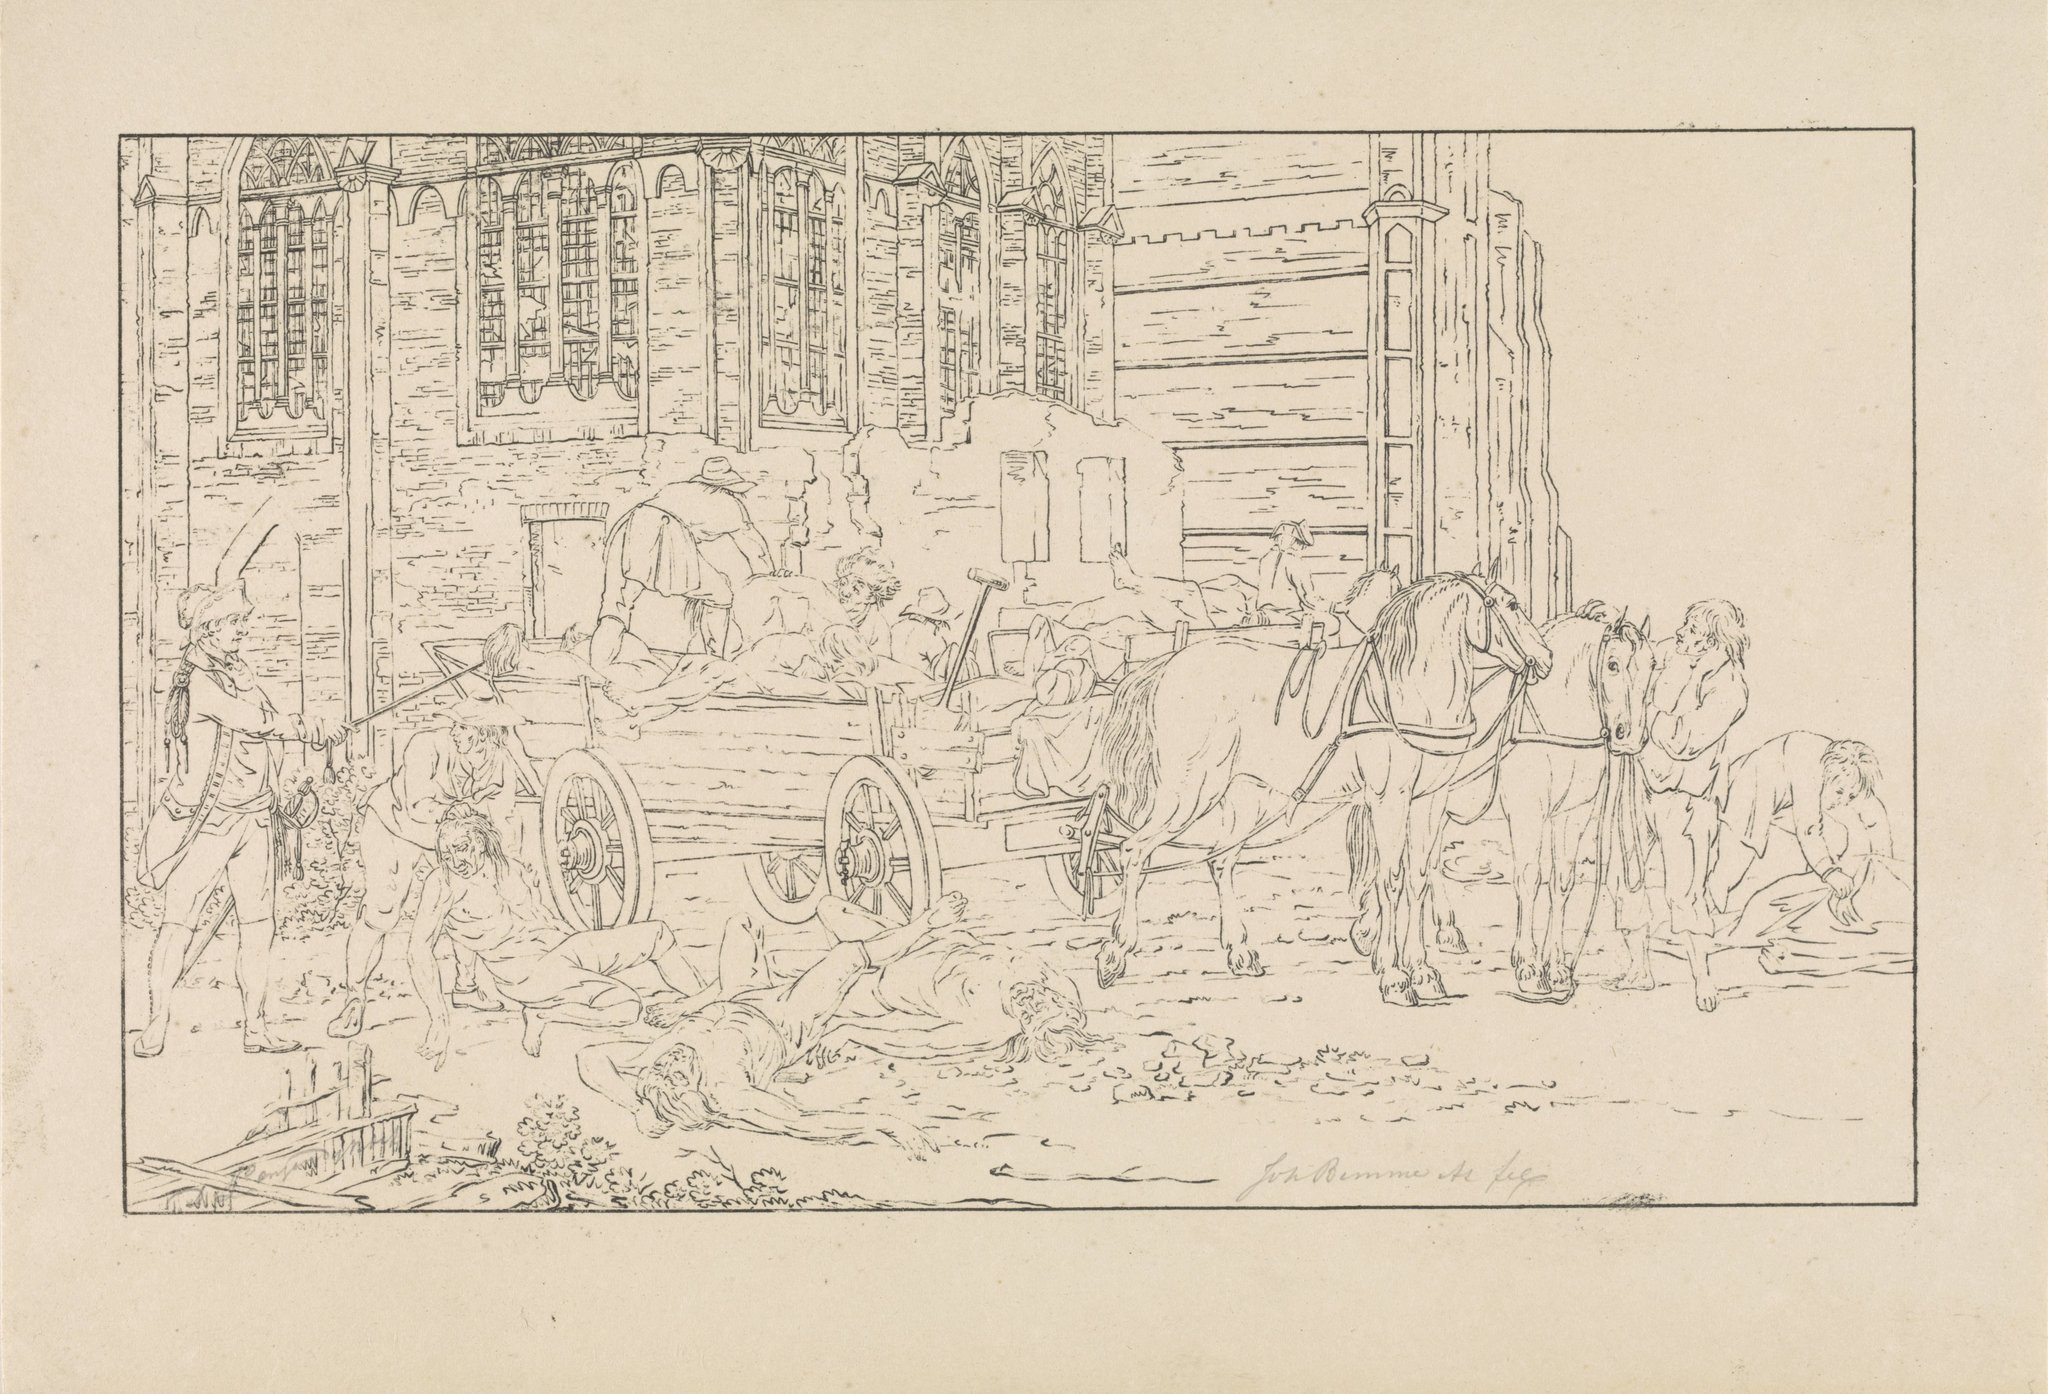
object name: print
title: Ophalen van lijken met karren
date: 1820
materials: paper, pencil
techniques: lithograph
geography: netherlands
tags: ruin of church, monastery, etc., the corpse, four-wheeled vehicle drawn by two animals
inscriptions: signature: ‘D. Langendijk del’, signature: ‘Joh Bemme Az Fec’, collector's mark: Lugt 2228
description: Voor een verwoeste kerk staan twee karren met paarden. Soldaten zijn bezig lijken op de karren te laden.